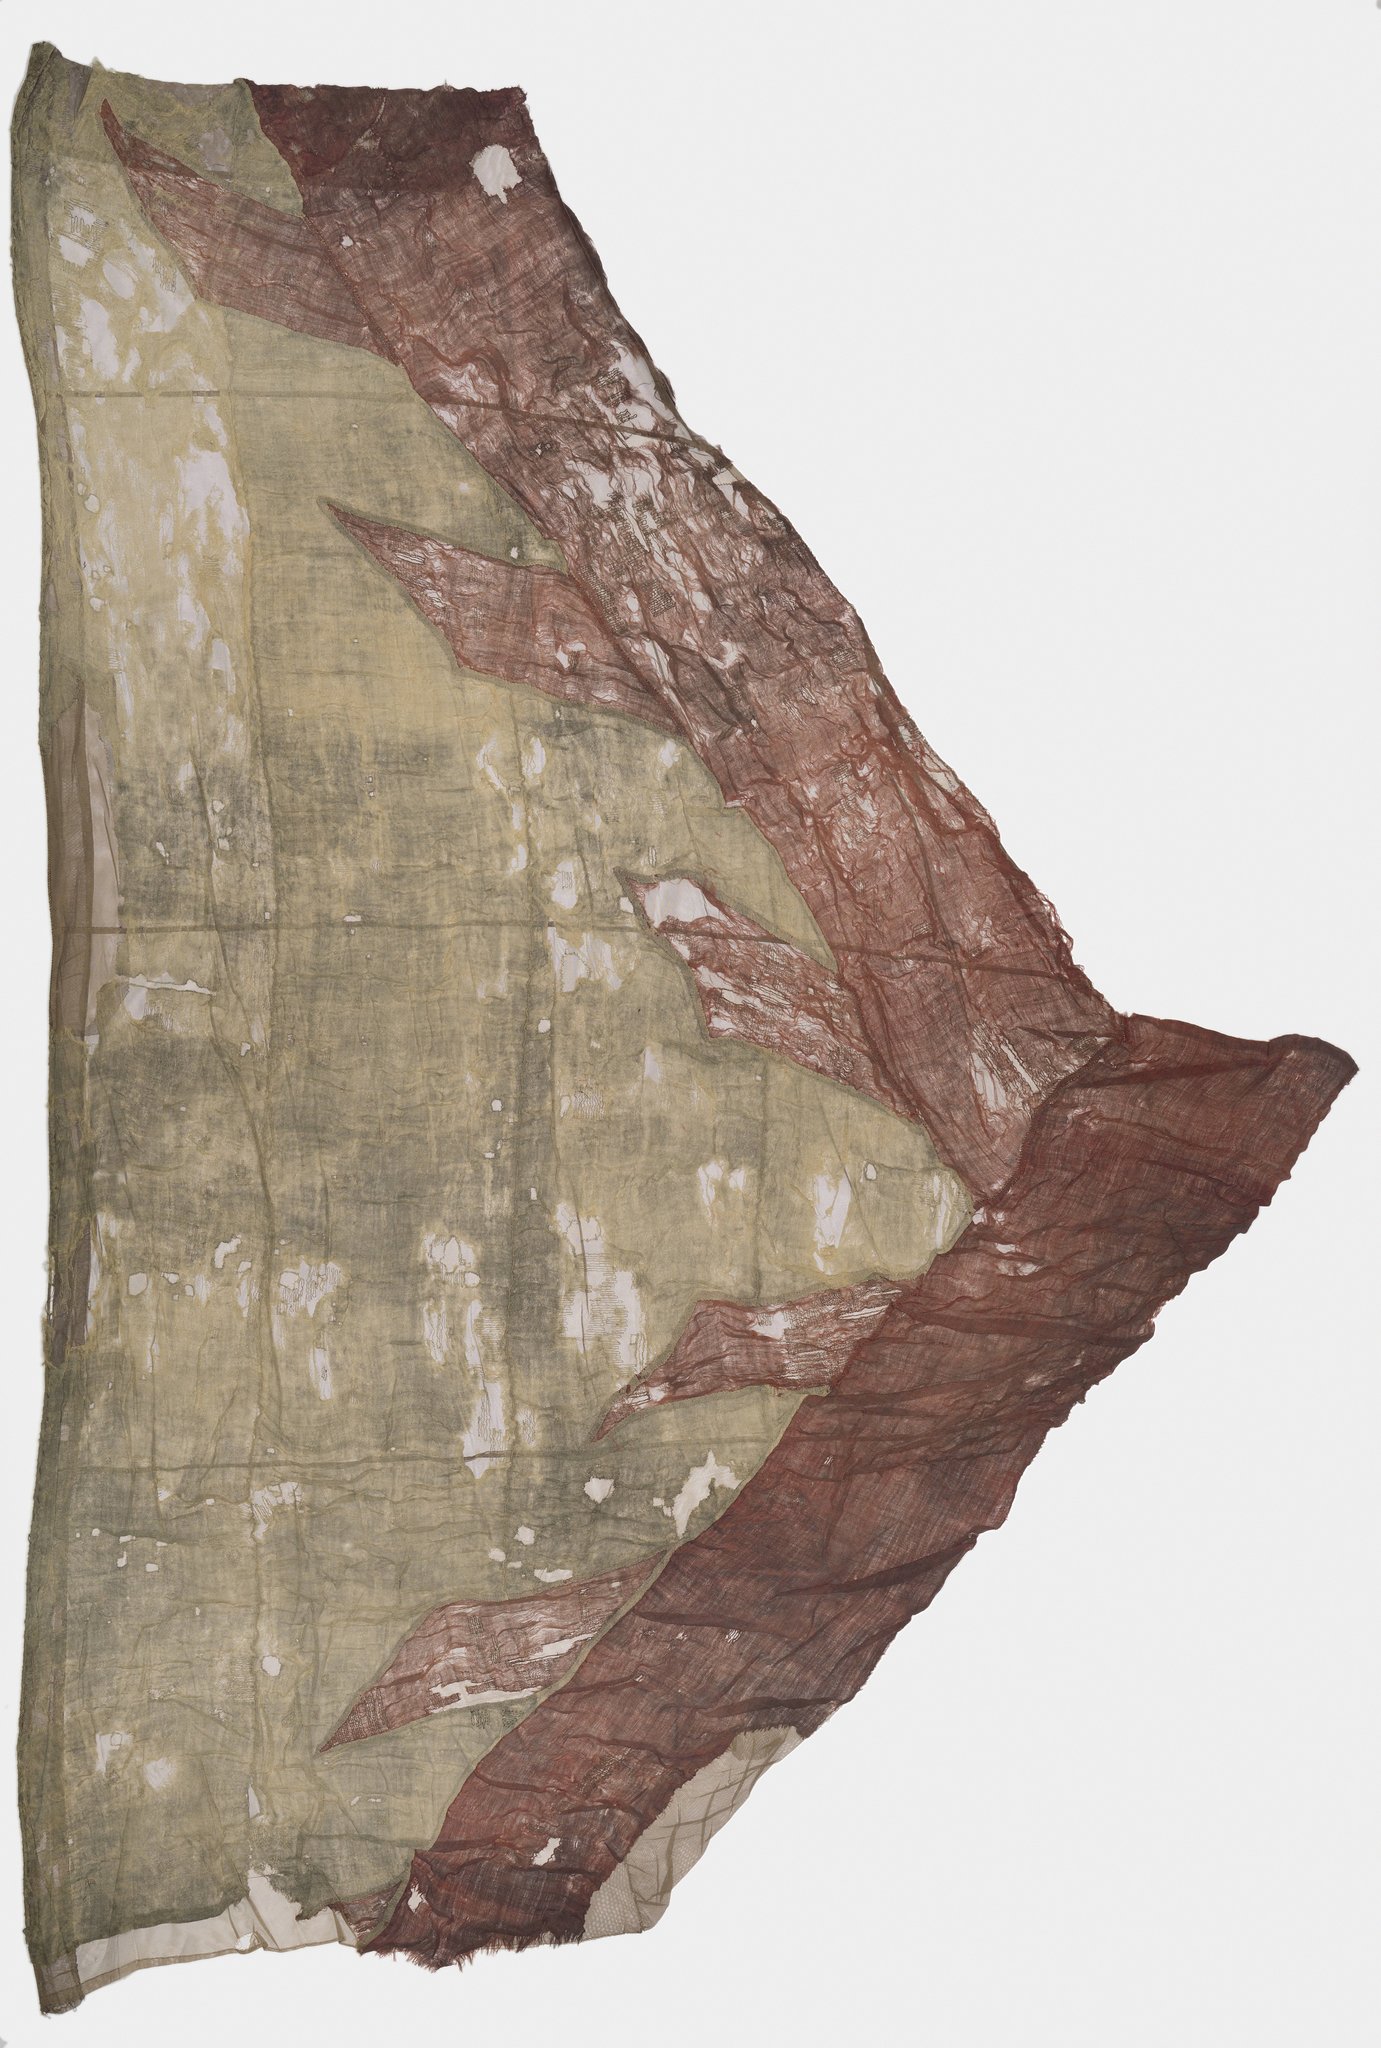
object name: ship flag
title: Fragment of a Ship Flag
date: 1570-1630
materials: wool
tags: flag, colours (as symbol of the state, etc.)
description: Deze Bourgondische vlag komt vanaf 1408 of 1411 voor, aanvankelijk met een blauw kruis, maar sinds Karel V met rood kruis.